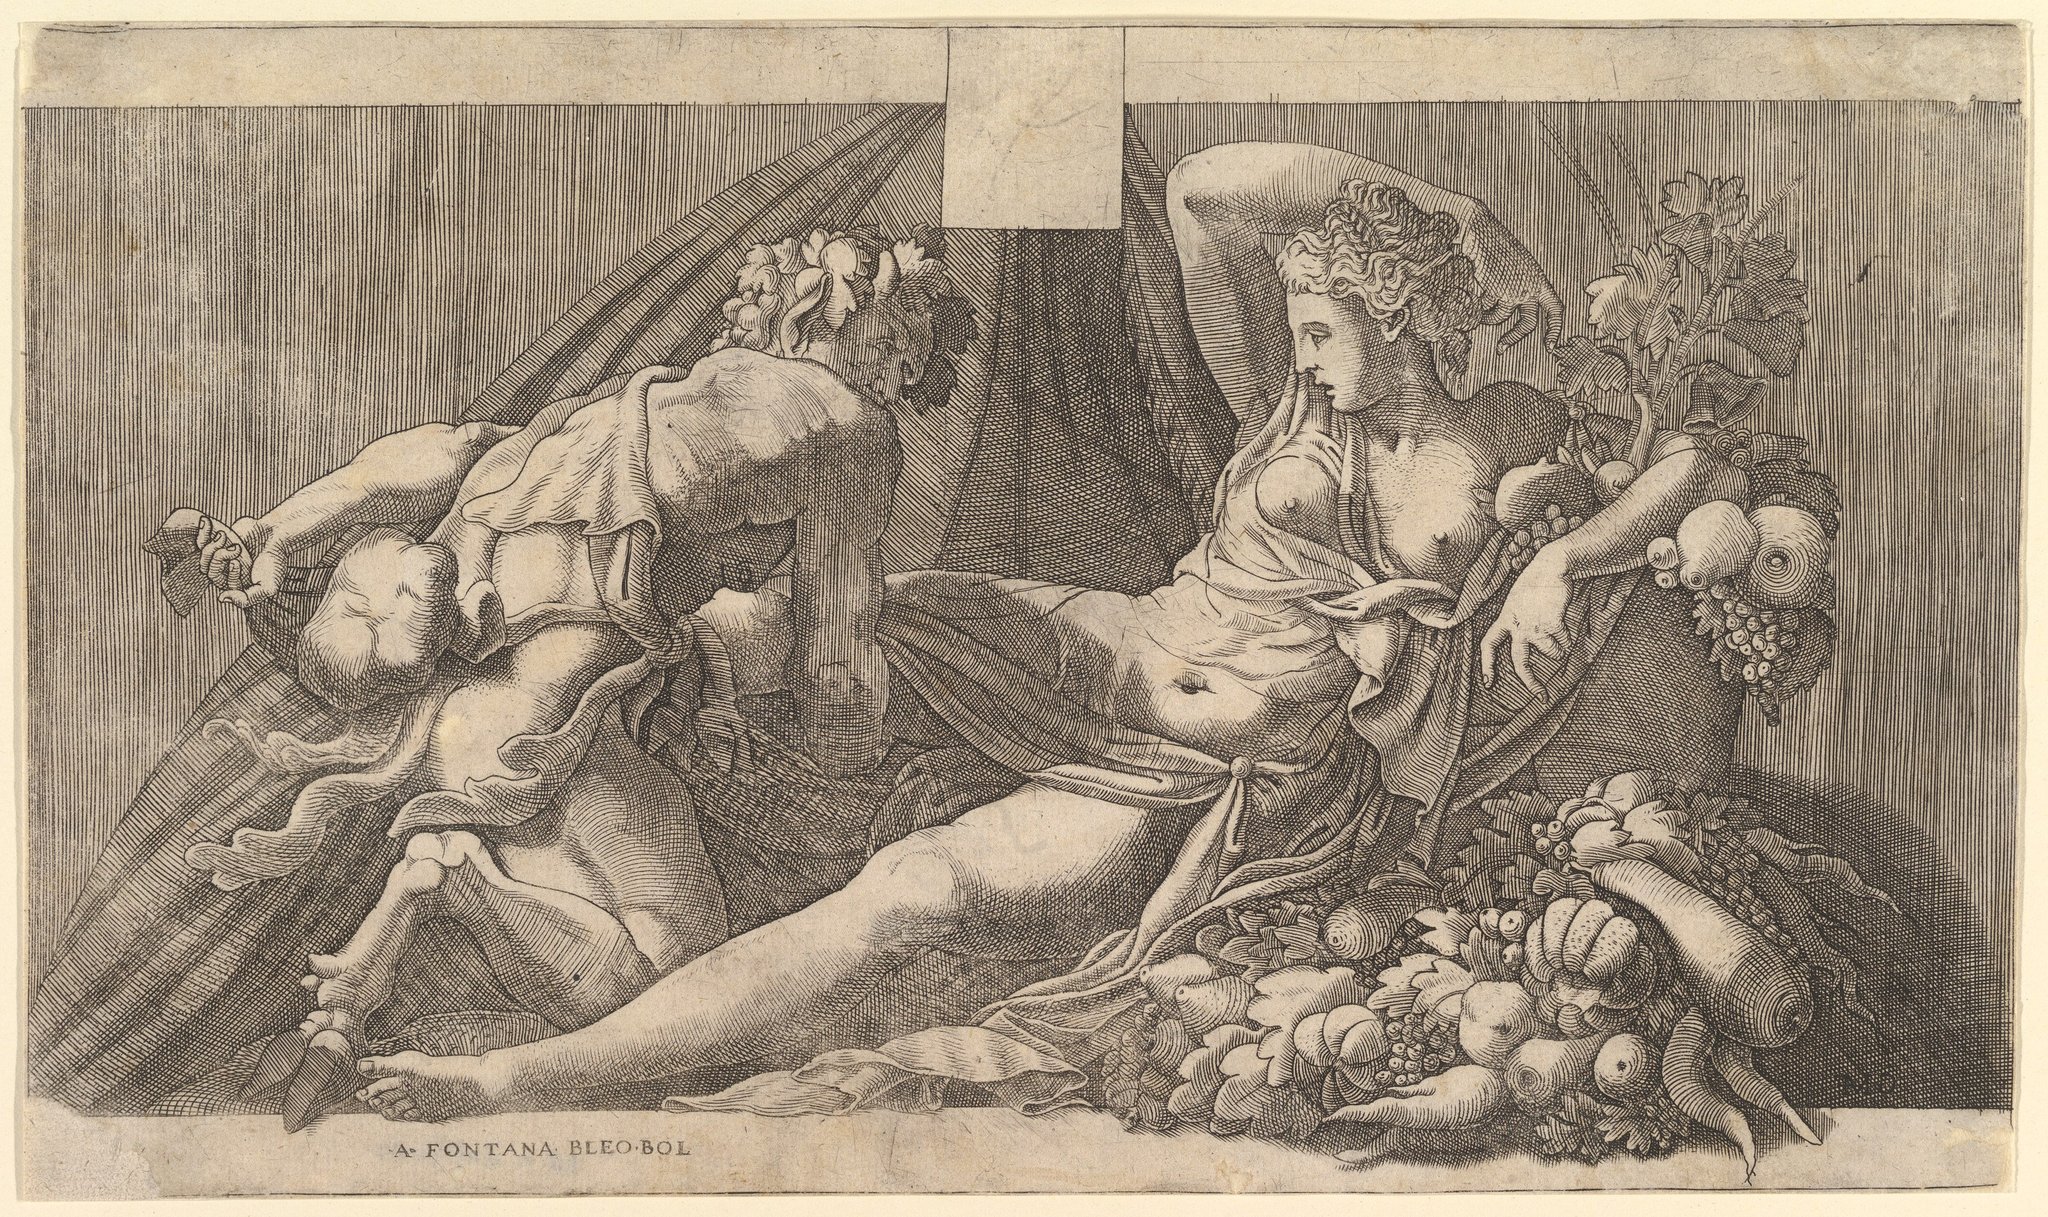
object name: print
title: Jupiter and Antiope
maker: master fg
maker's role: artist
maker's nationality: italian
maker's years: 1530-1560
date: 1520-1582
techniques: engraving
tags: female nudes,jupiter,satyrs